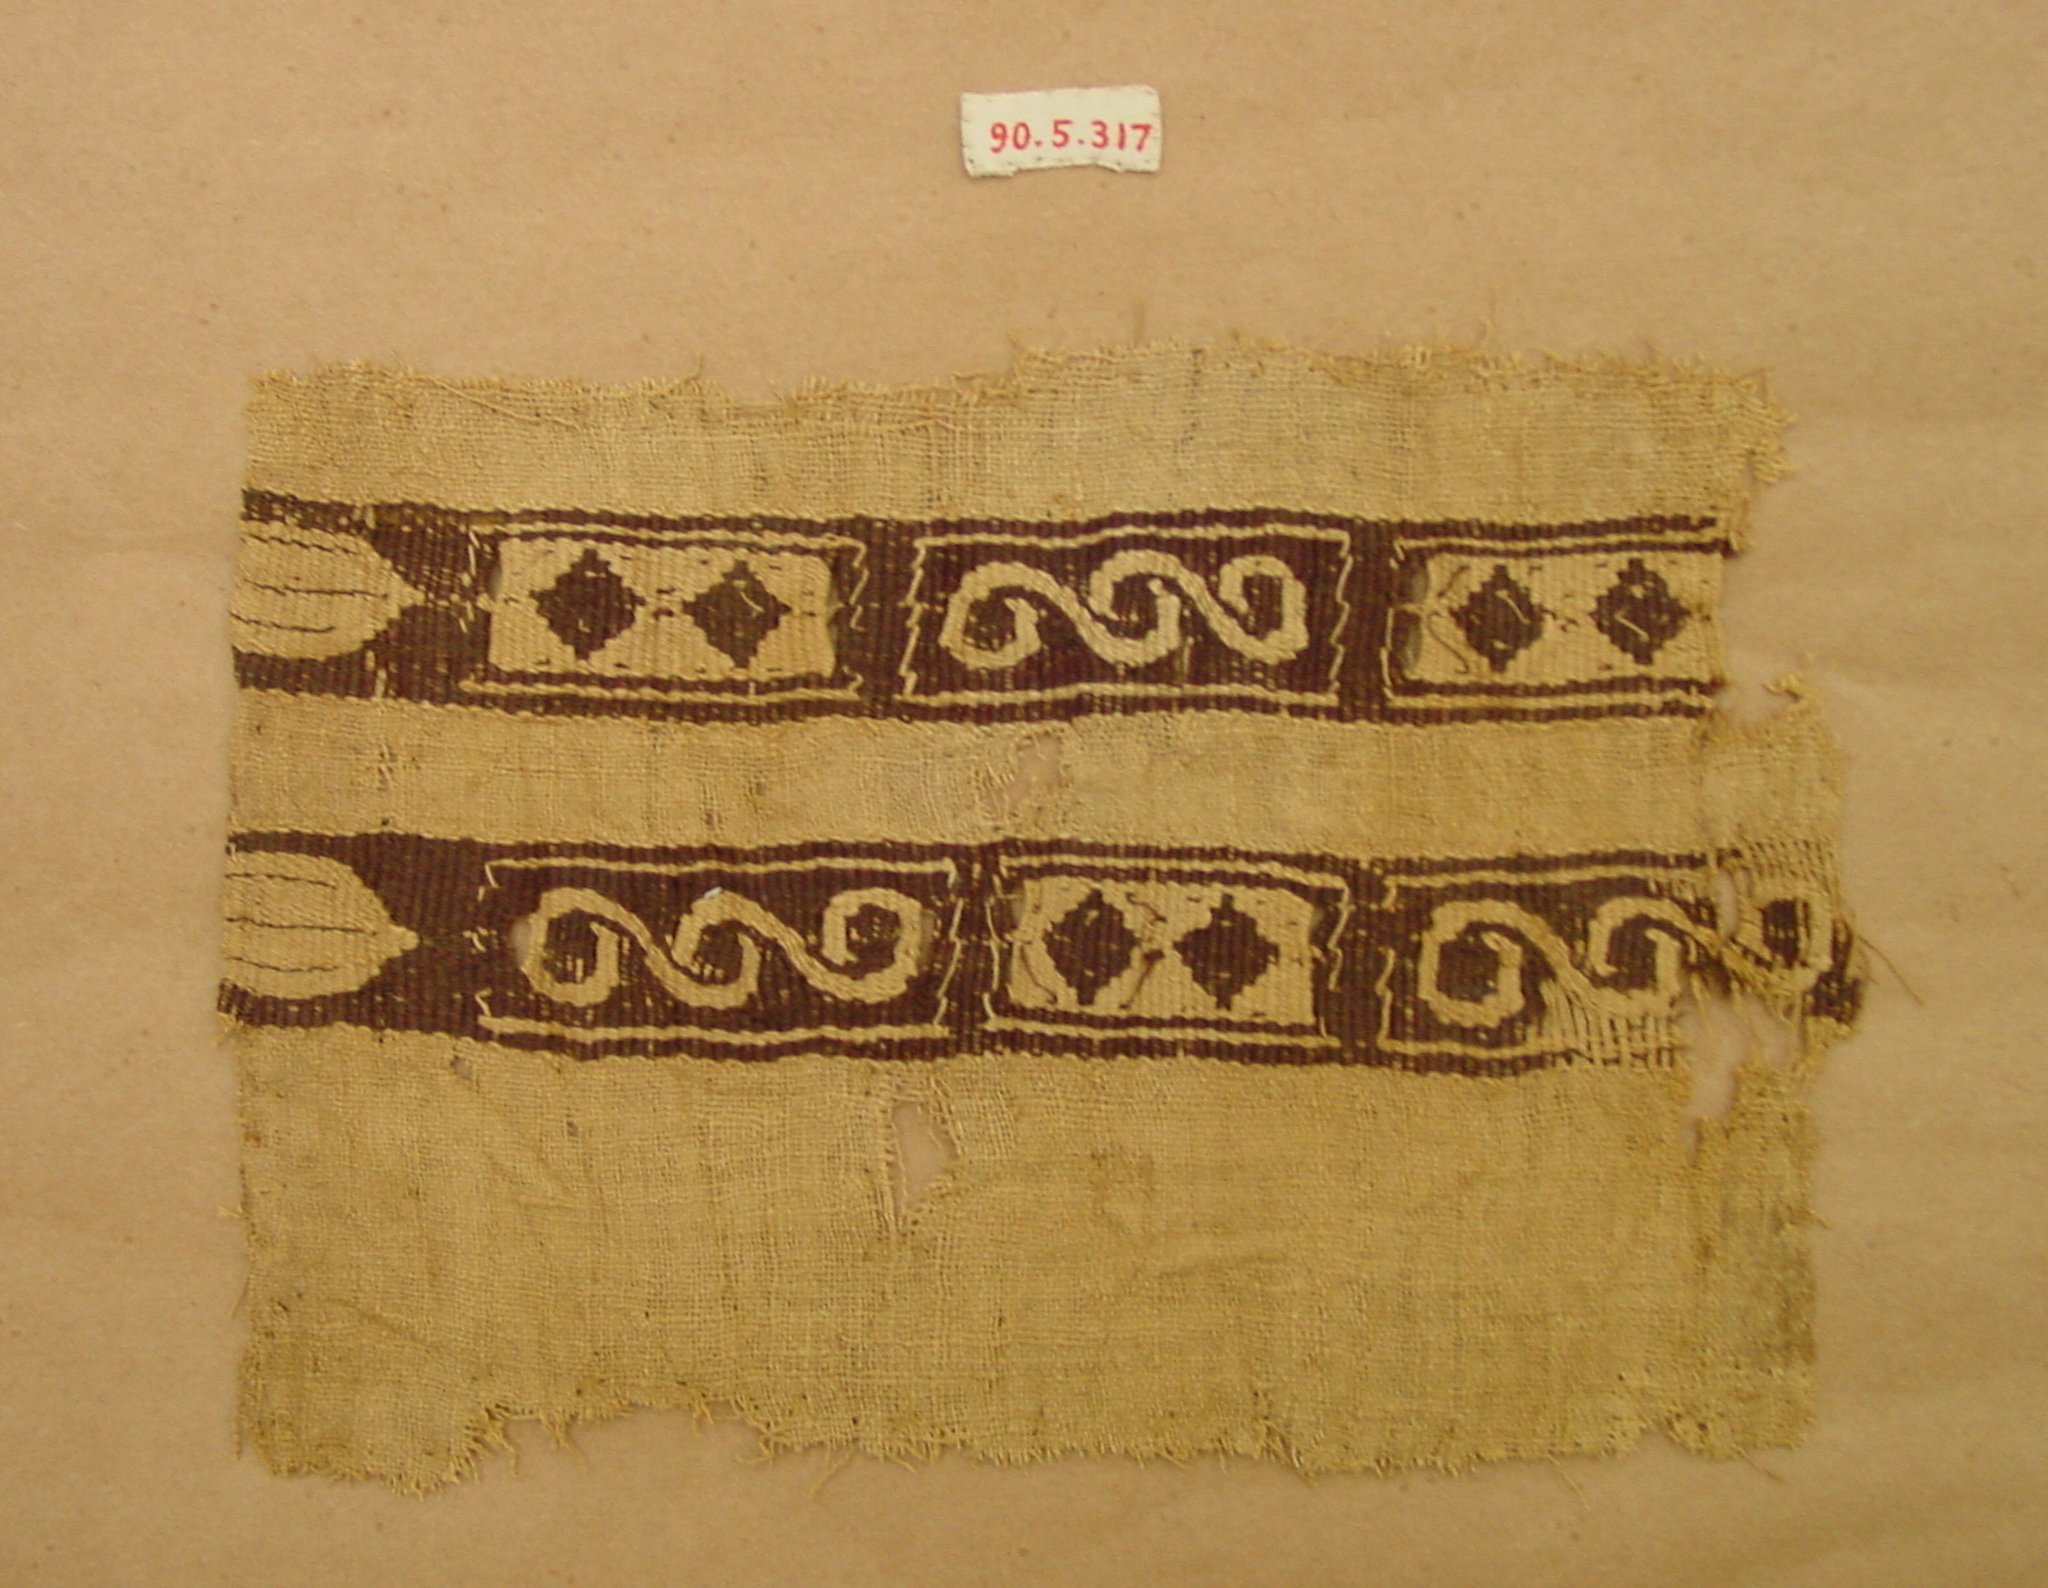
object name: textile fragment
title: Fragment of a Sleeve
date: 201-400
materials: linen, wool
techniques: weave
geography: egypt